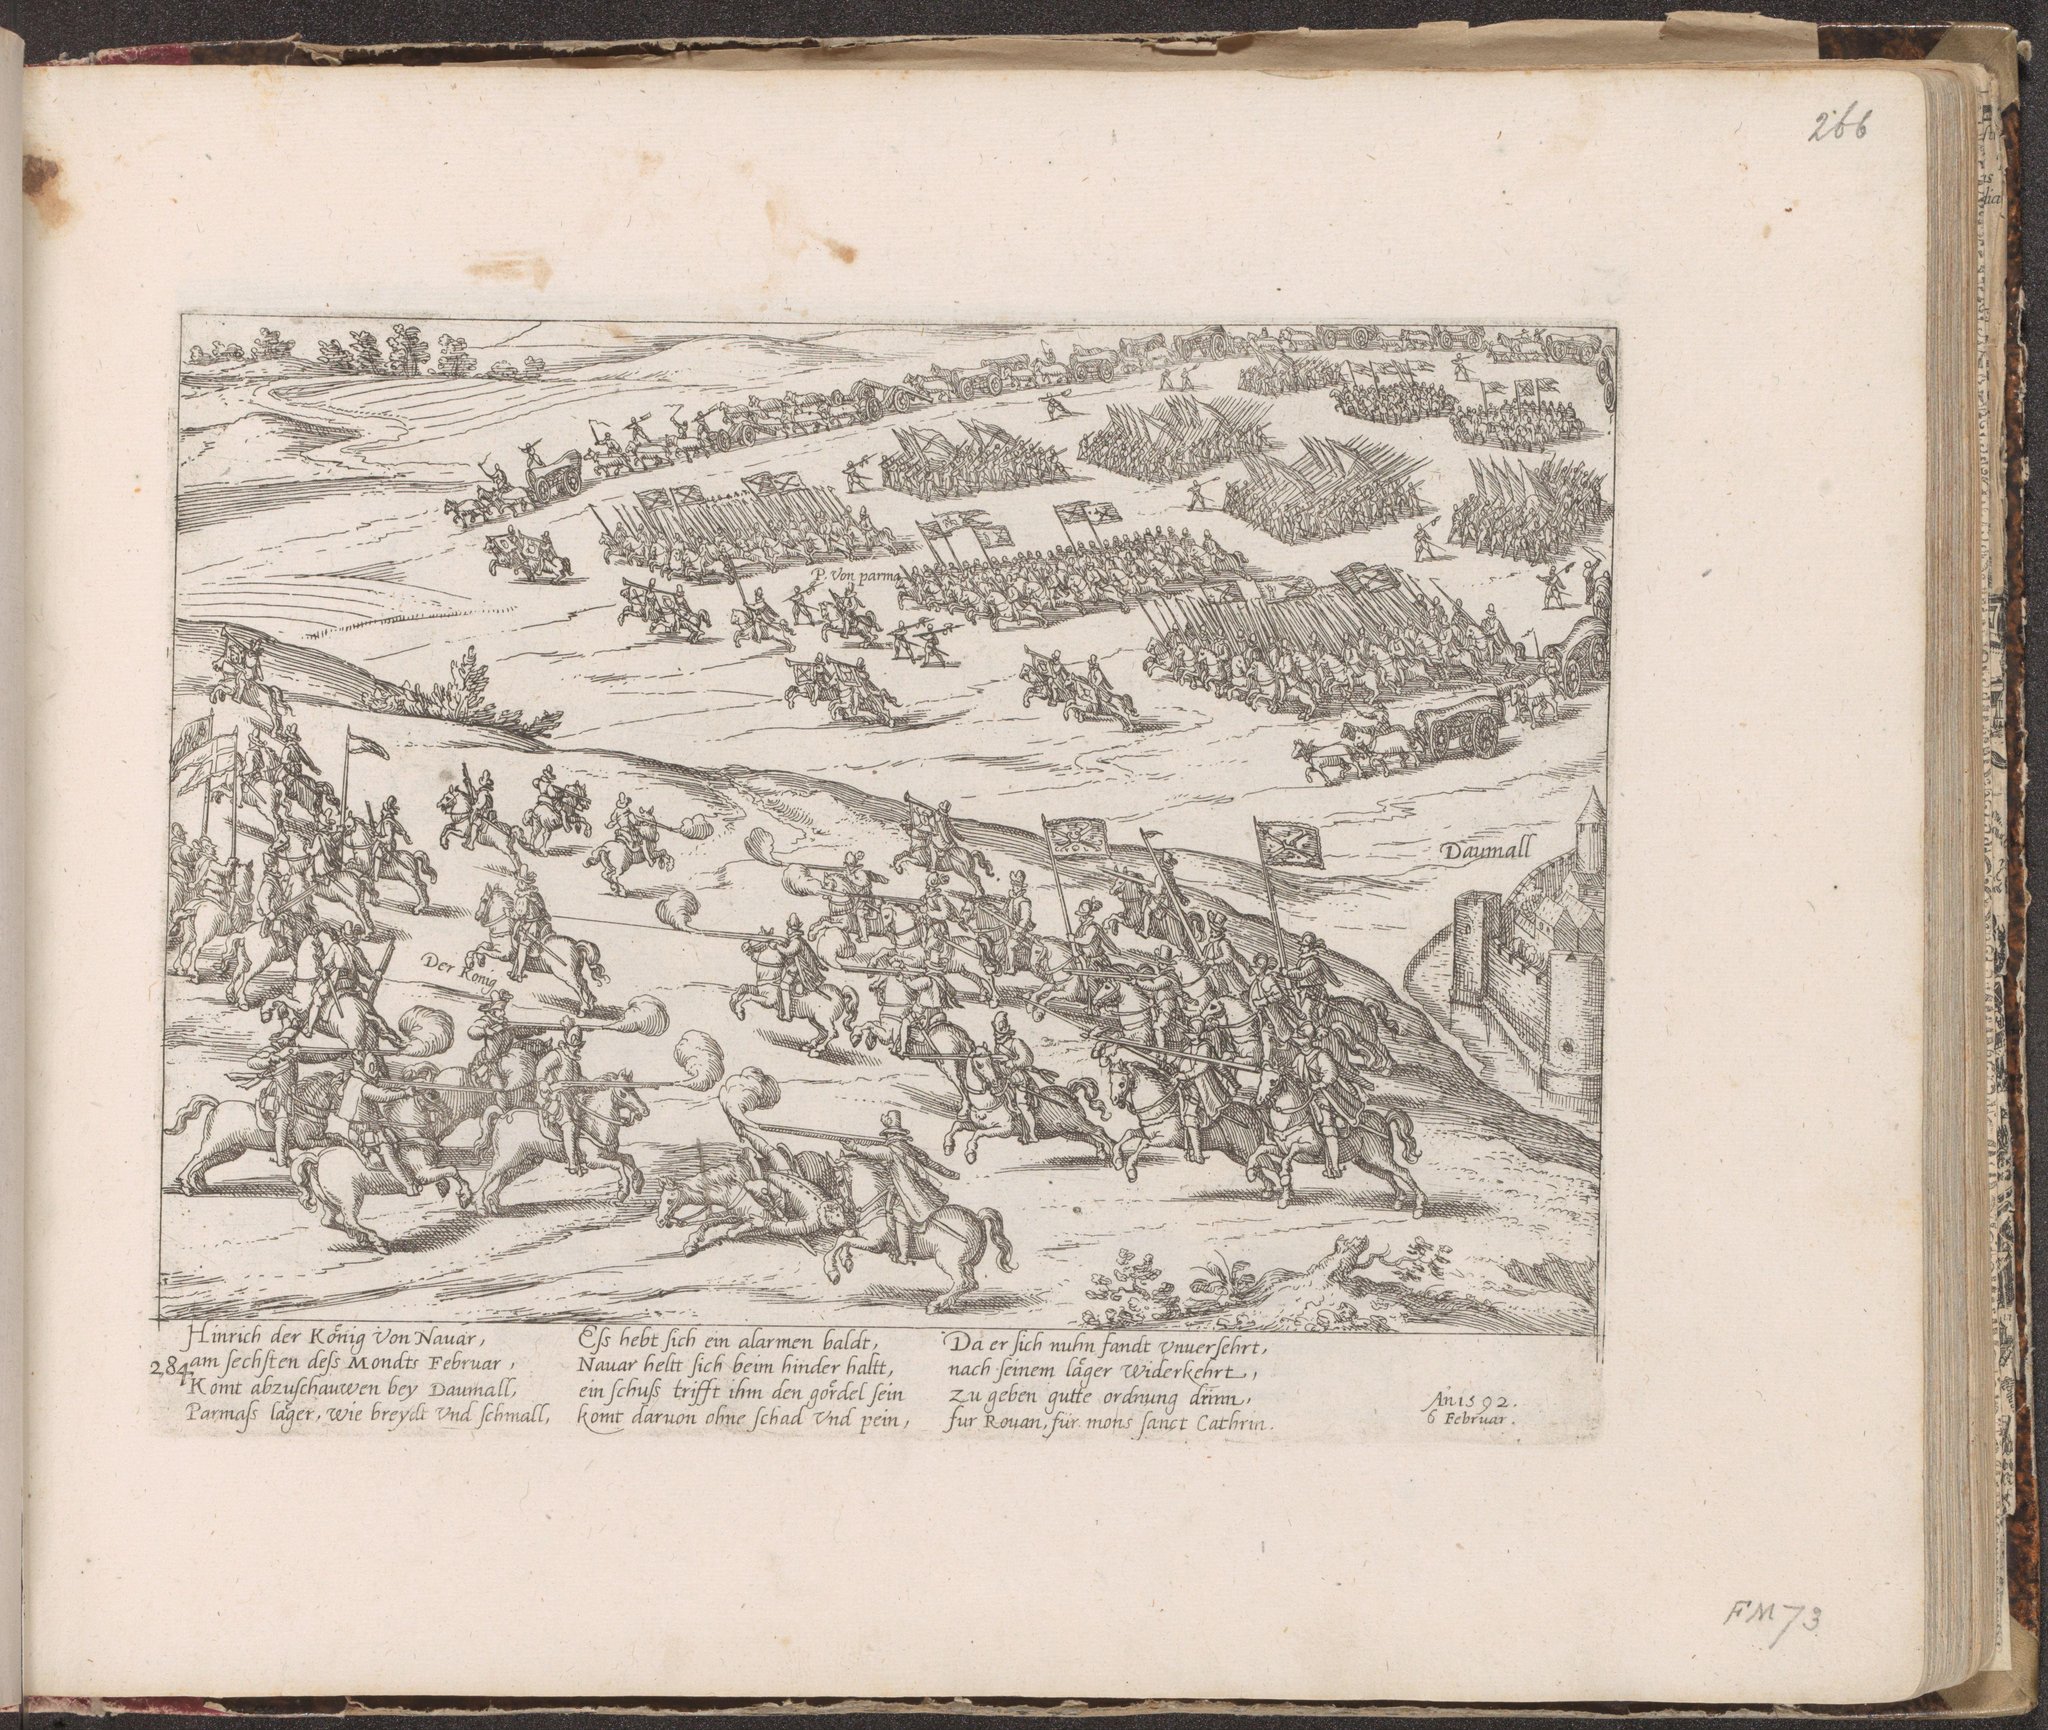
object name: history print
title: Serie 4: Franse, Duitse en Engelse Gebeurtenissen, 1576-1610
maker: frans hogenberg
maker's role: print maker, publisher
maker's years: 1538-1590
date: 1592-1594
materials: paper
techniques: etching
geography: cologne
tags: rome, alessandro farnese (landvoogd van de nederlanden en hertog van parma en piacenza), paris, hendrik iv (koning van frankrijk en navarra), battle, fighting in general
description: Hendrik IV treft het leger van de hertog van Parma bij Aumale, 6 februari 1592. De koning raakt bij dit treffen gewond. Met onderschrift van 12 regels in het Duits. Linksonder genummerd: 284. De prent maakt deel uit van een album.